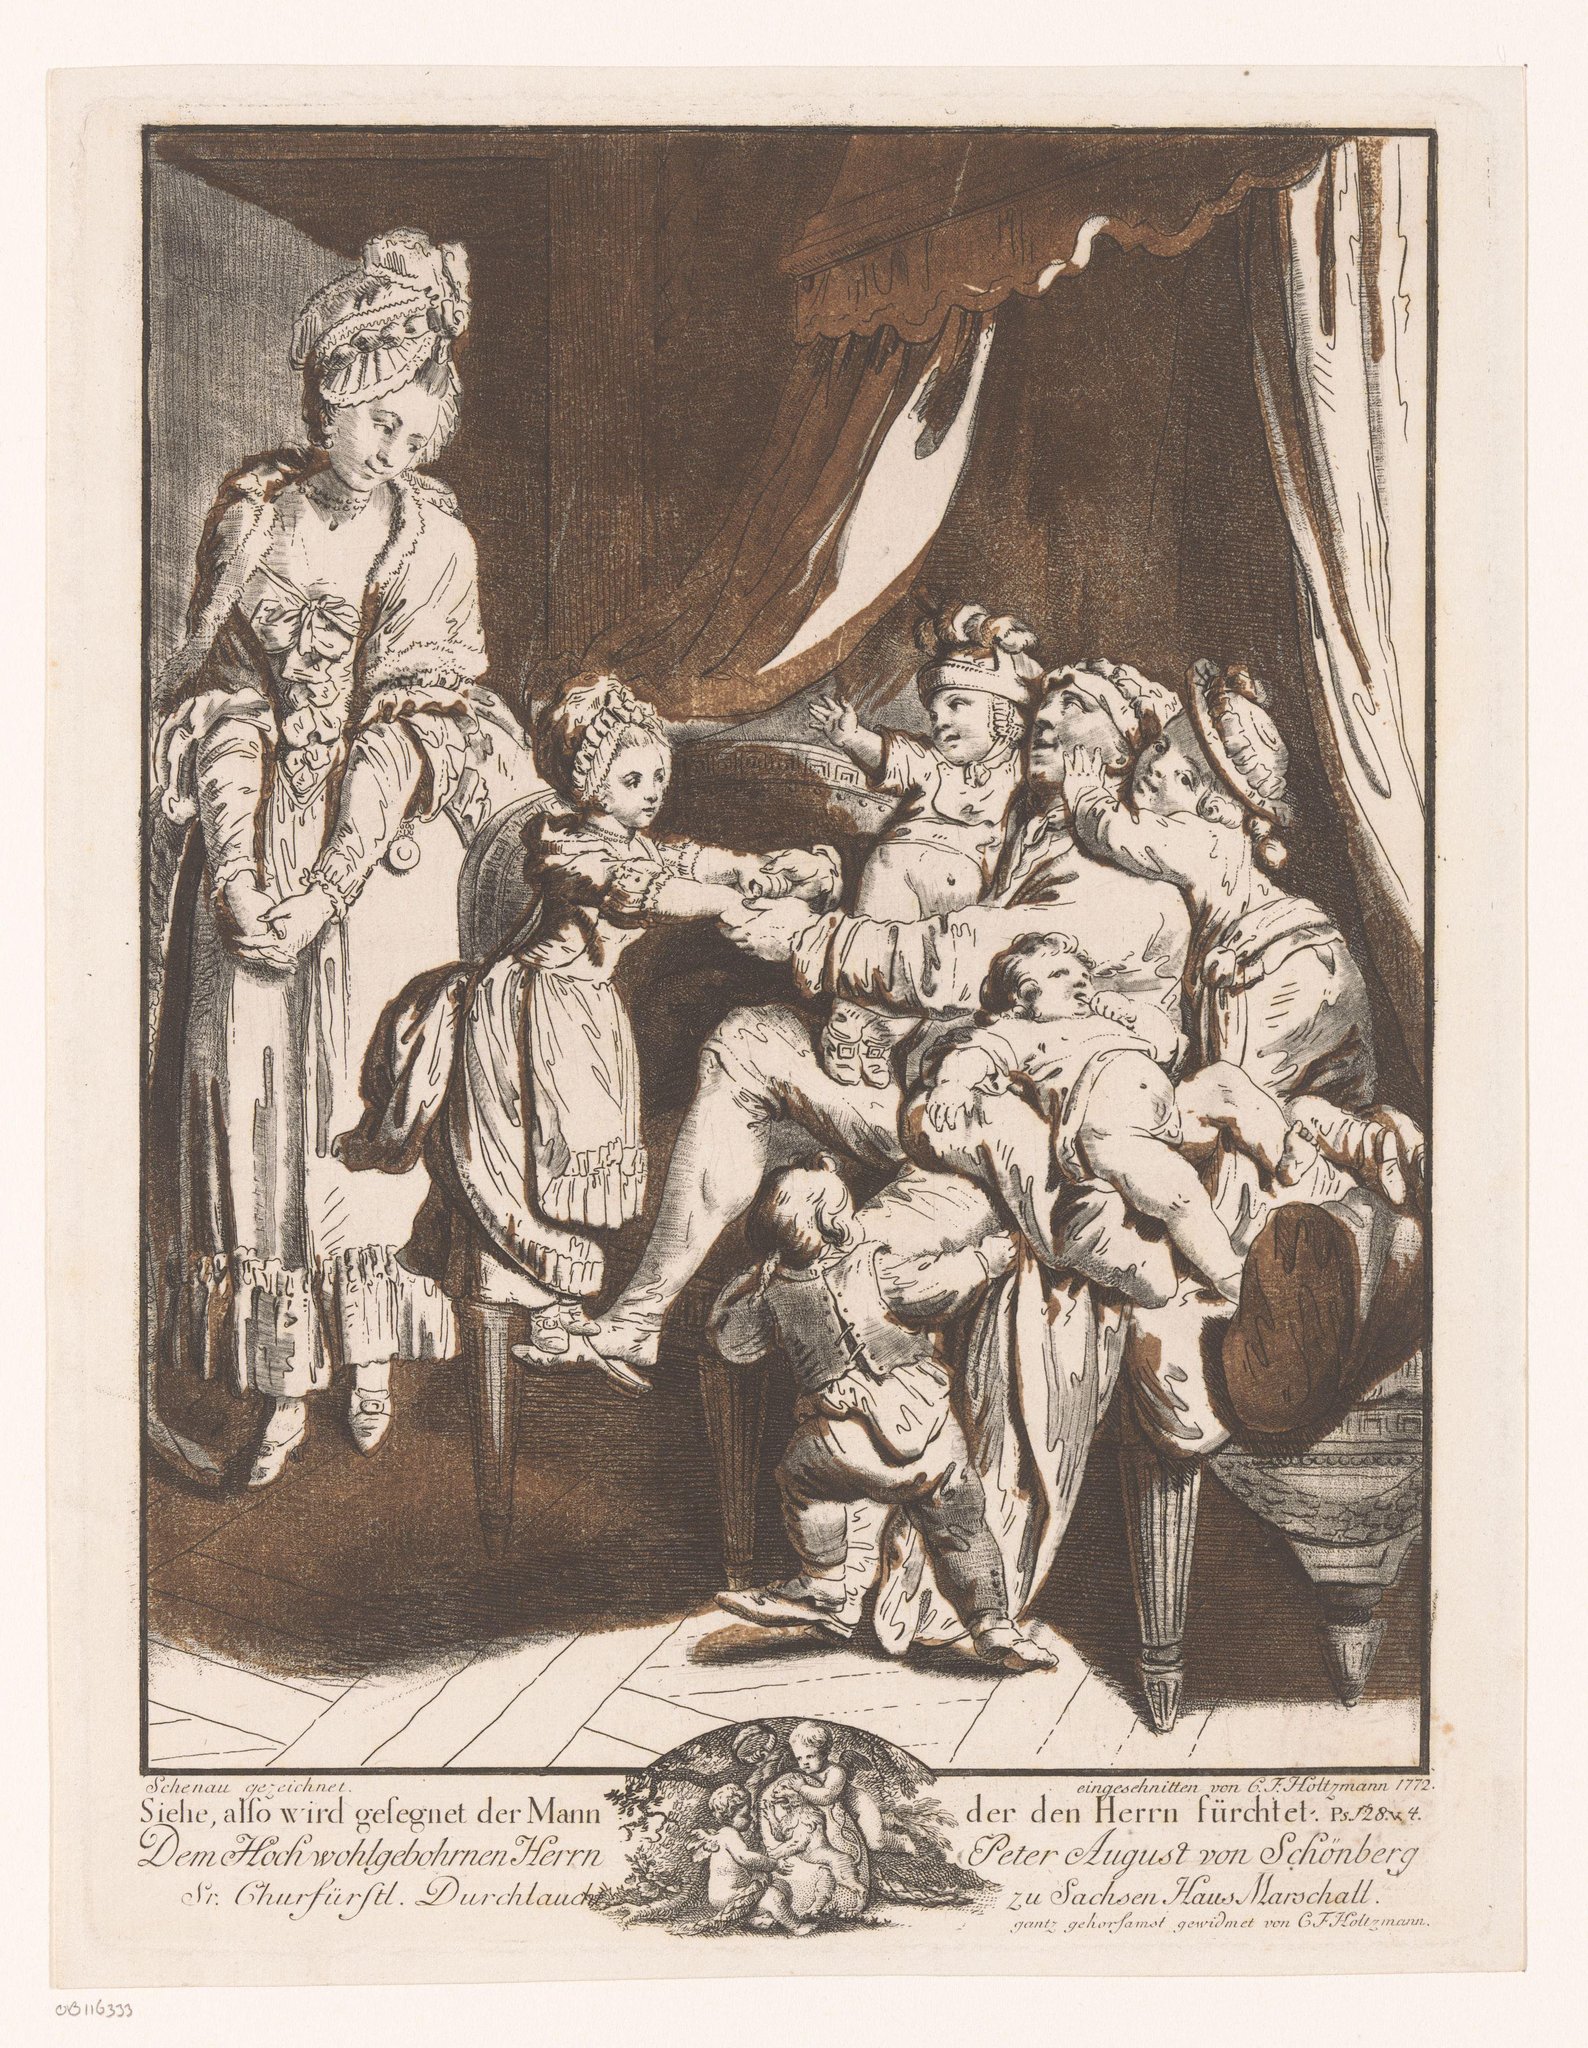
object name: print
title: Man op een bank omringd door vijf kinderen terwijl zijn vrouw naast hem staat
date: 1772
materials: paper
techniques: aquatint, etching, intaglio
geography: dresden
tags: the book of psalms (with book chapter:verse), family group, especially parents with their child(ren), ornament ~ medallion, cupids: 'amores', 'amoretti', 'putti'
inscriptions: collector's mark: Lugt 240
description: Onder de voorstelling een éénregelige tekst uit Psalm 128 vers 4 in het Duits.